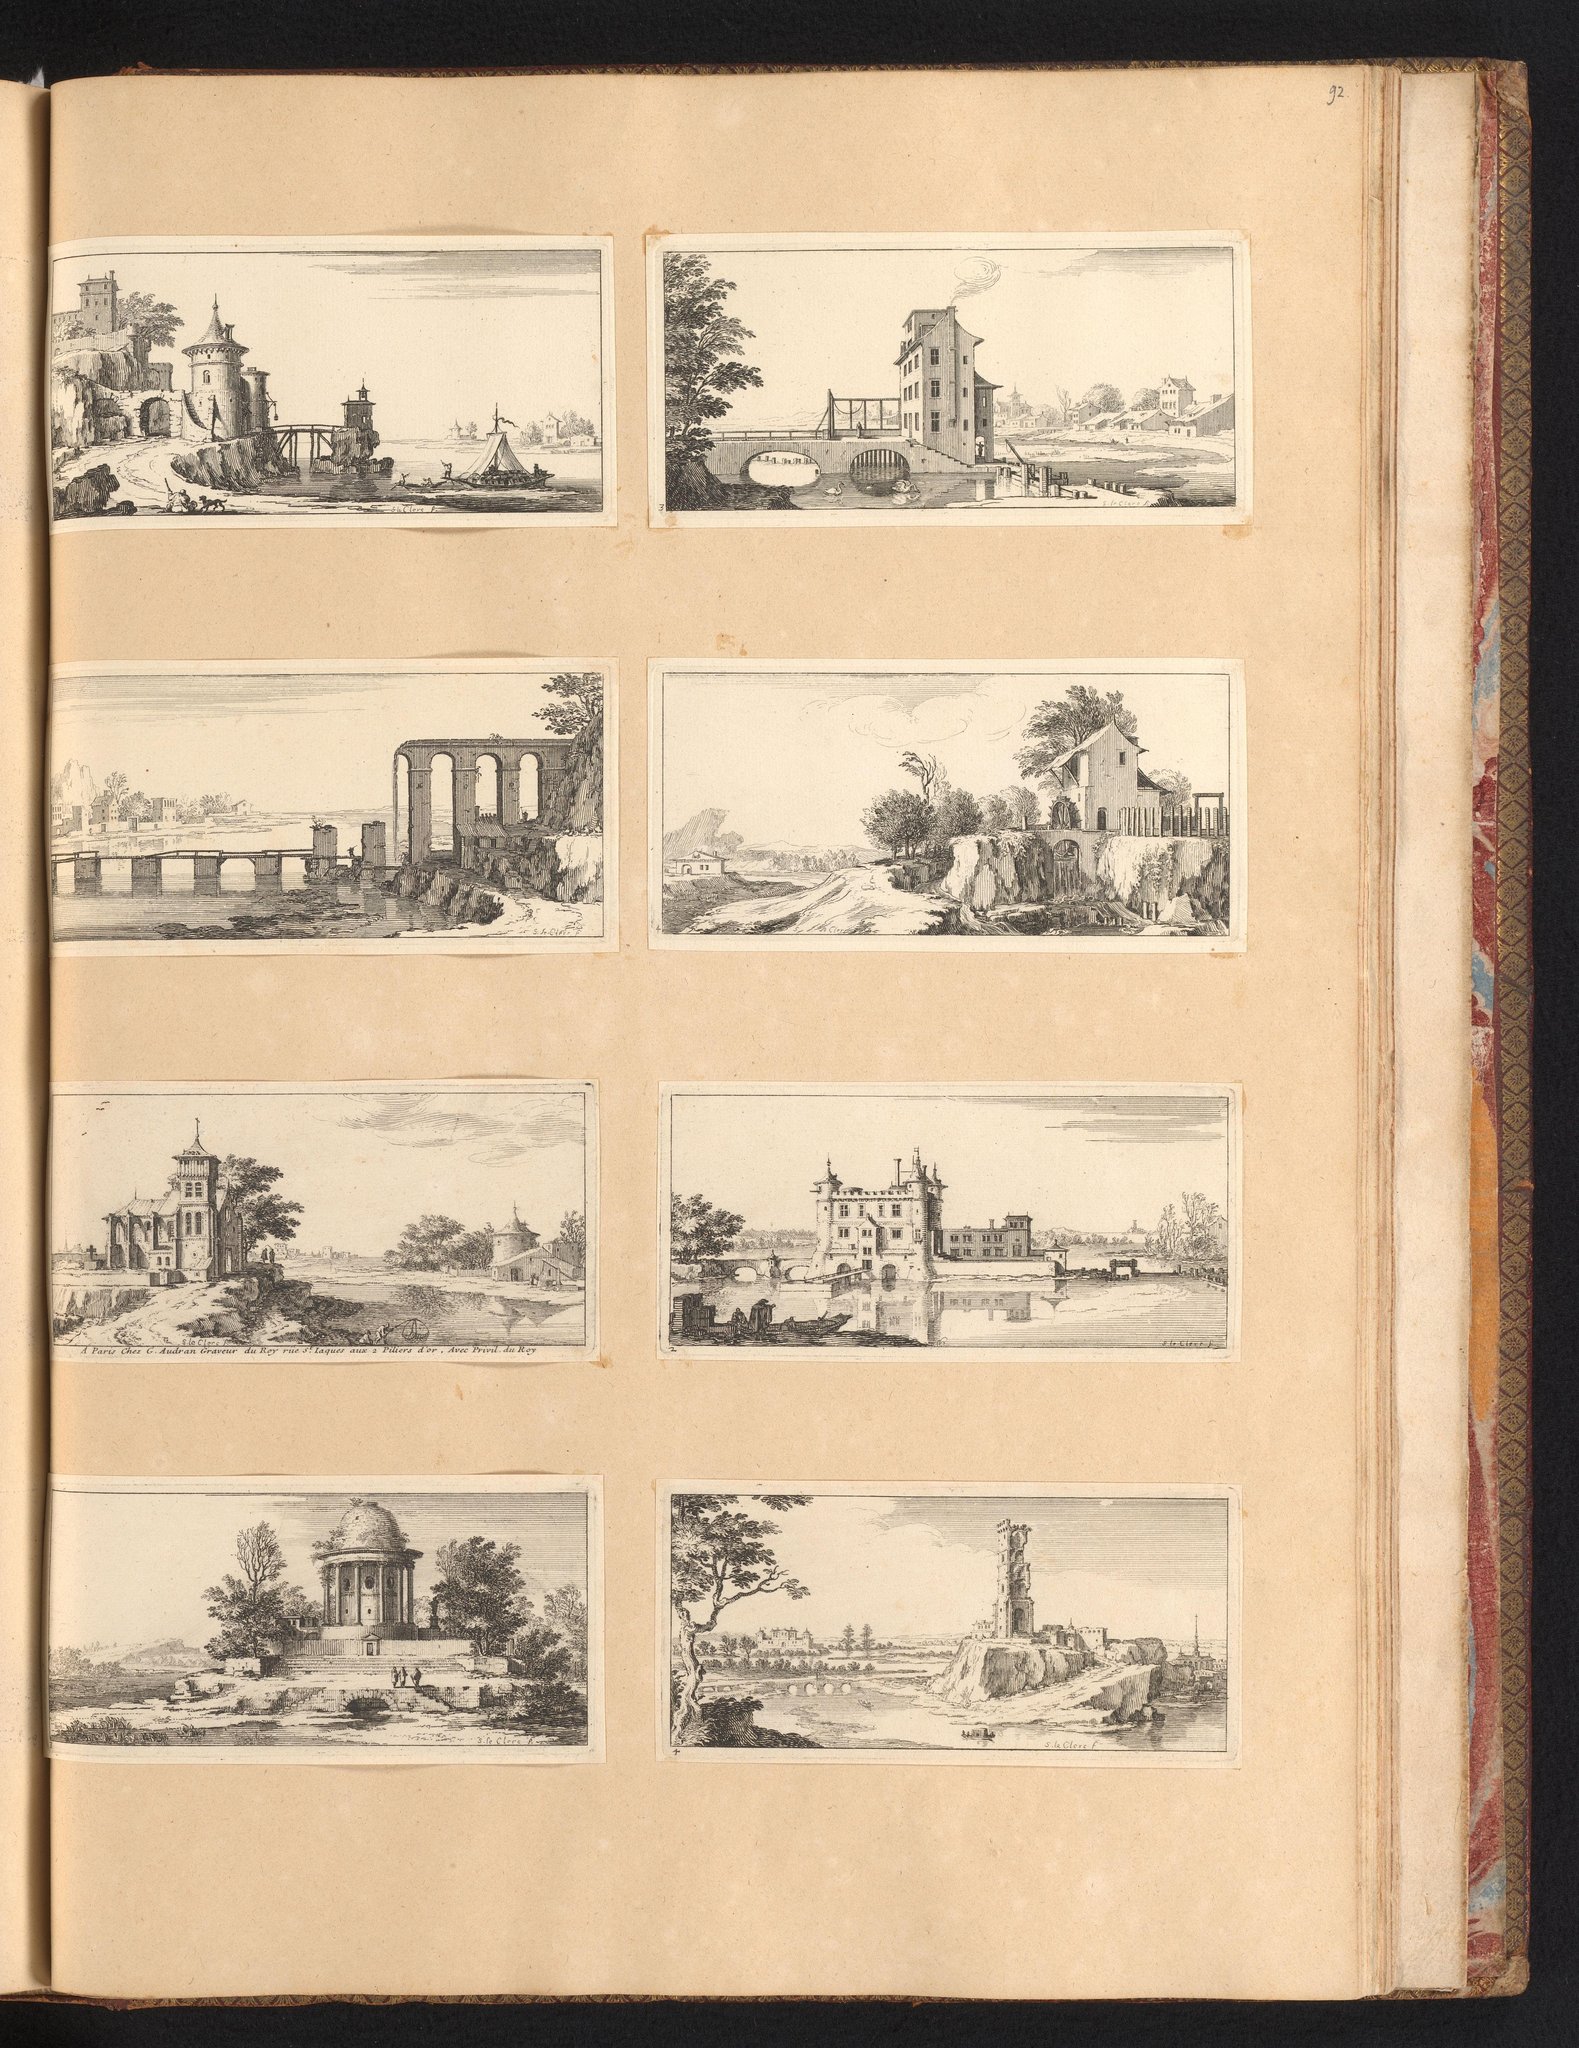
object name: print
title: Quelques Figures Chevaux paysages present's a Monseigneur le Duc de Bourgogne (...)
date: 1696-1700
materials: paper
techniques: etching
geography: france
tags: model-books ~ implements of painter, civic architecture; edifices; dwellings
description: Deze prenten maken deel uit van een zestigdelige serie met verschillende reeksen bestaande uit figuren, paarden, landschappen en gebouwen. De serie werd onderverdeeld in negen boeken, waarvan acht boeken met ieder zes prenten en één met twaalf prenten. Leclerc vervaardigde deze reeks voor Lodewijk van Frankrijk om diens tekenles te faciliteren.